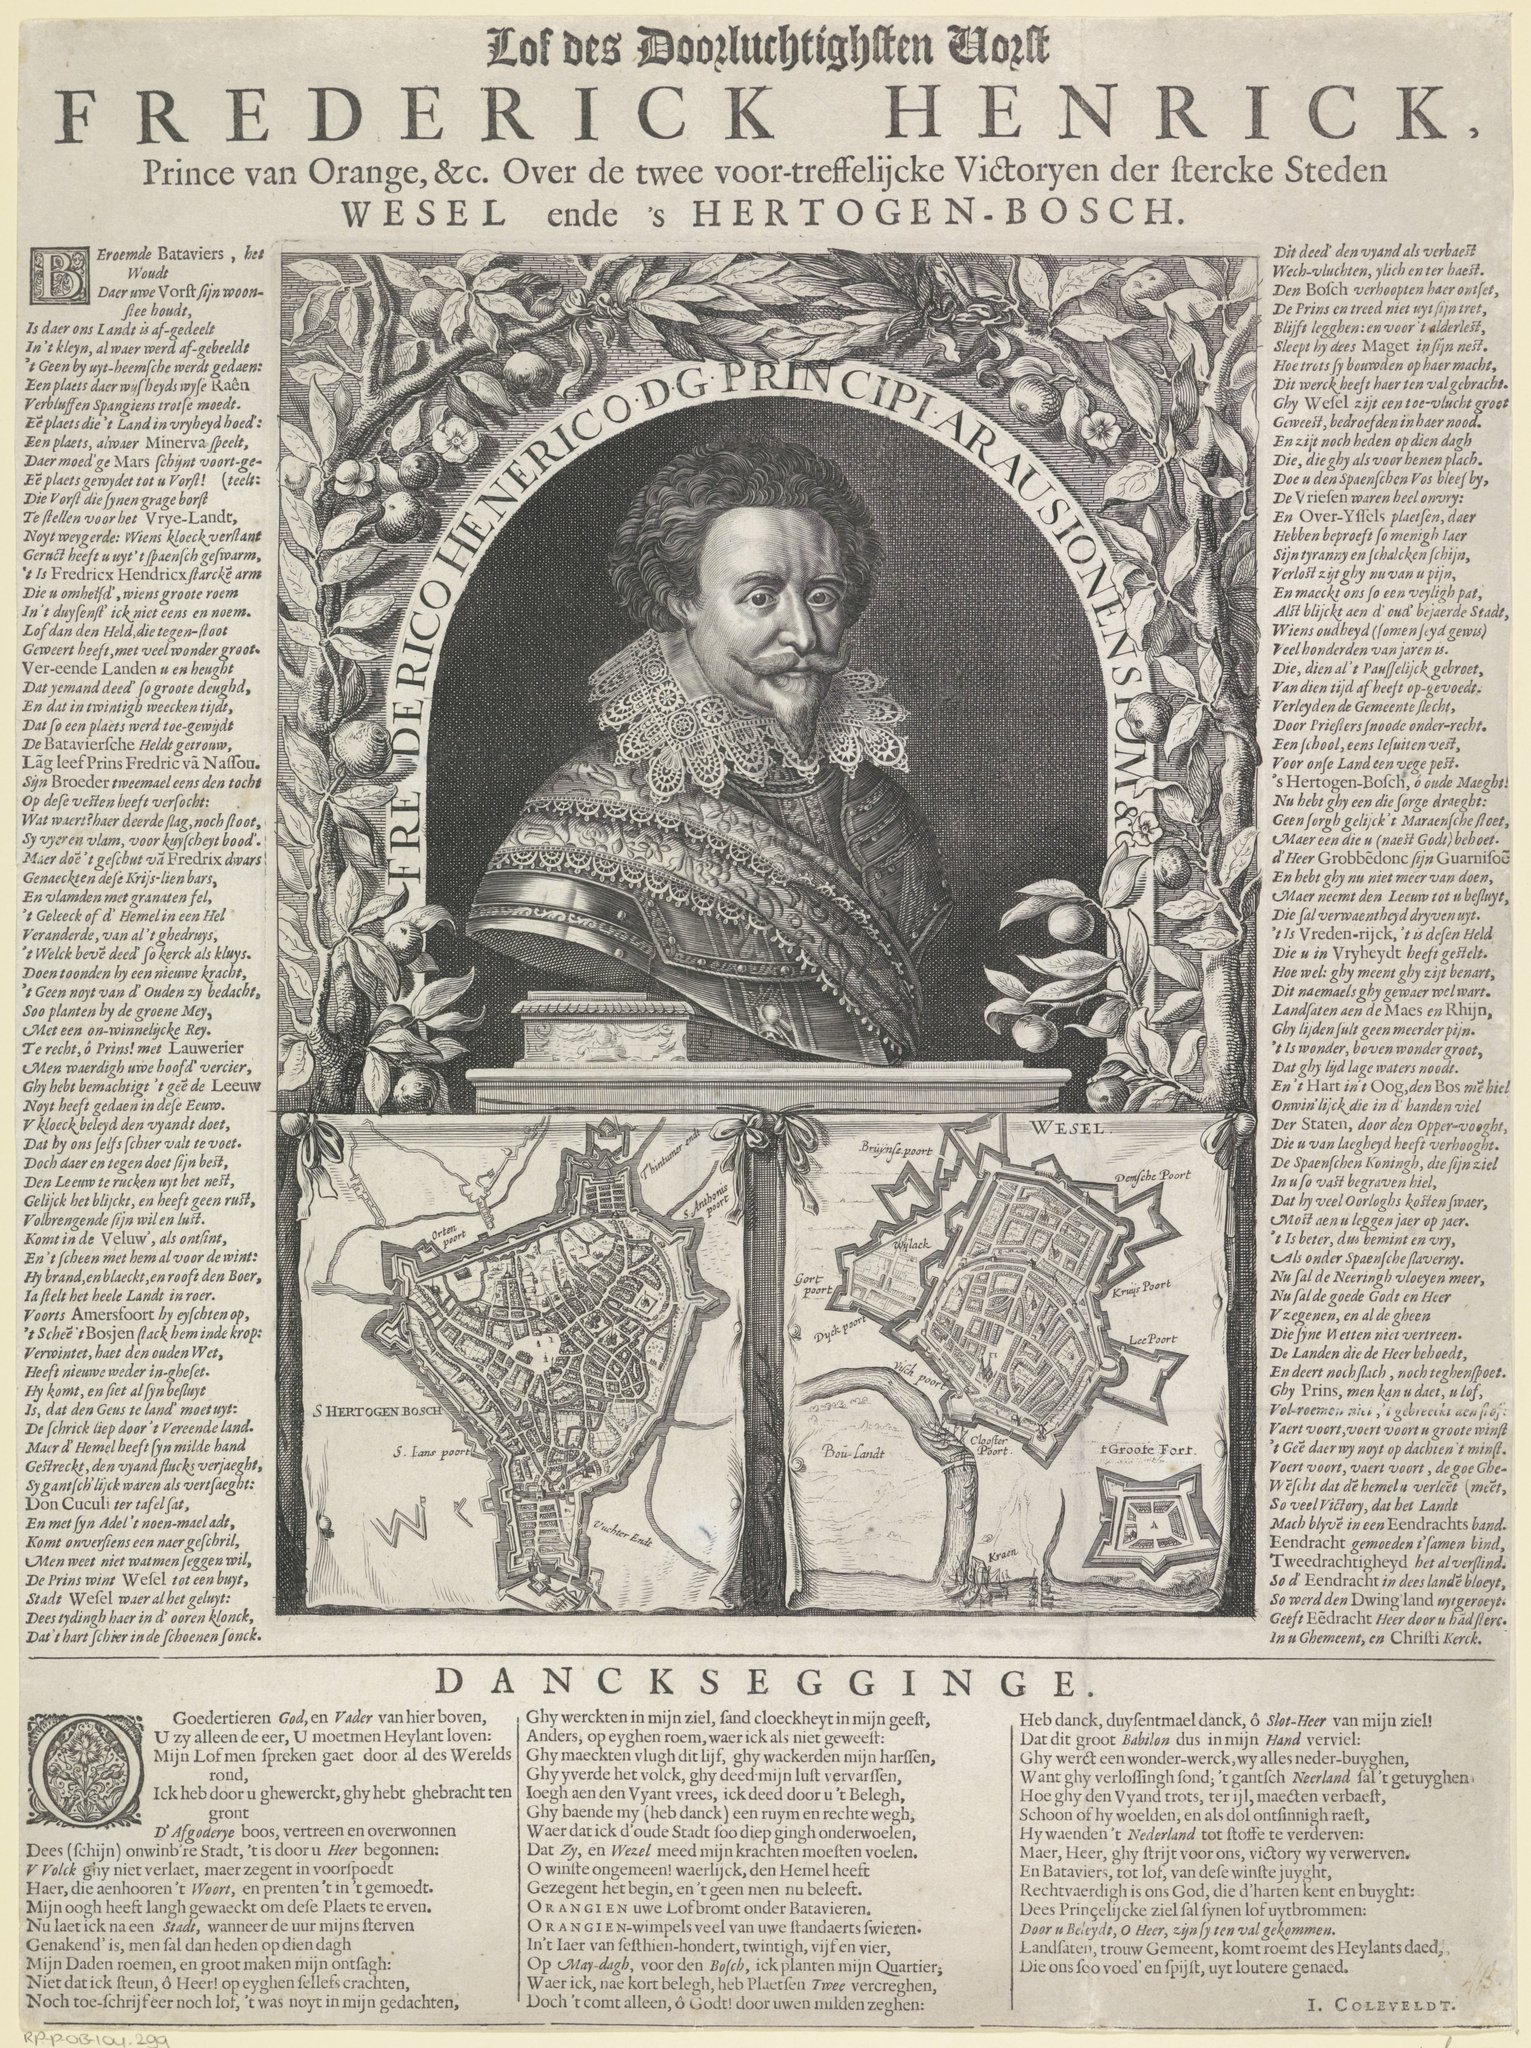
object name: print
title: Buste van Frederik Hendrik, prins van Oranje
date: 1629-1631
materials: paper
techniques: engraving, etching, letterpress printing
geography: low countries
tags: the hague, frederick henry (prince of orange), piece of sculpture, reproduction of a piece of sculpture, den bosch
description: Buste van Frederik Hendrik onder een toog met randschrift. Daar omheen oranjetakken en de plattegronden van Den bosch en Wesel. Rondom twee kolommen met een lofvers en drie kolommen met een dankzegging.